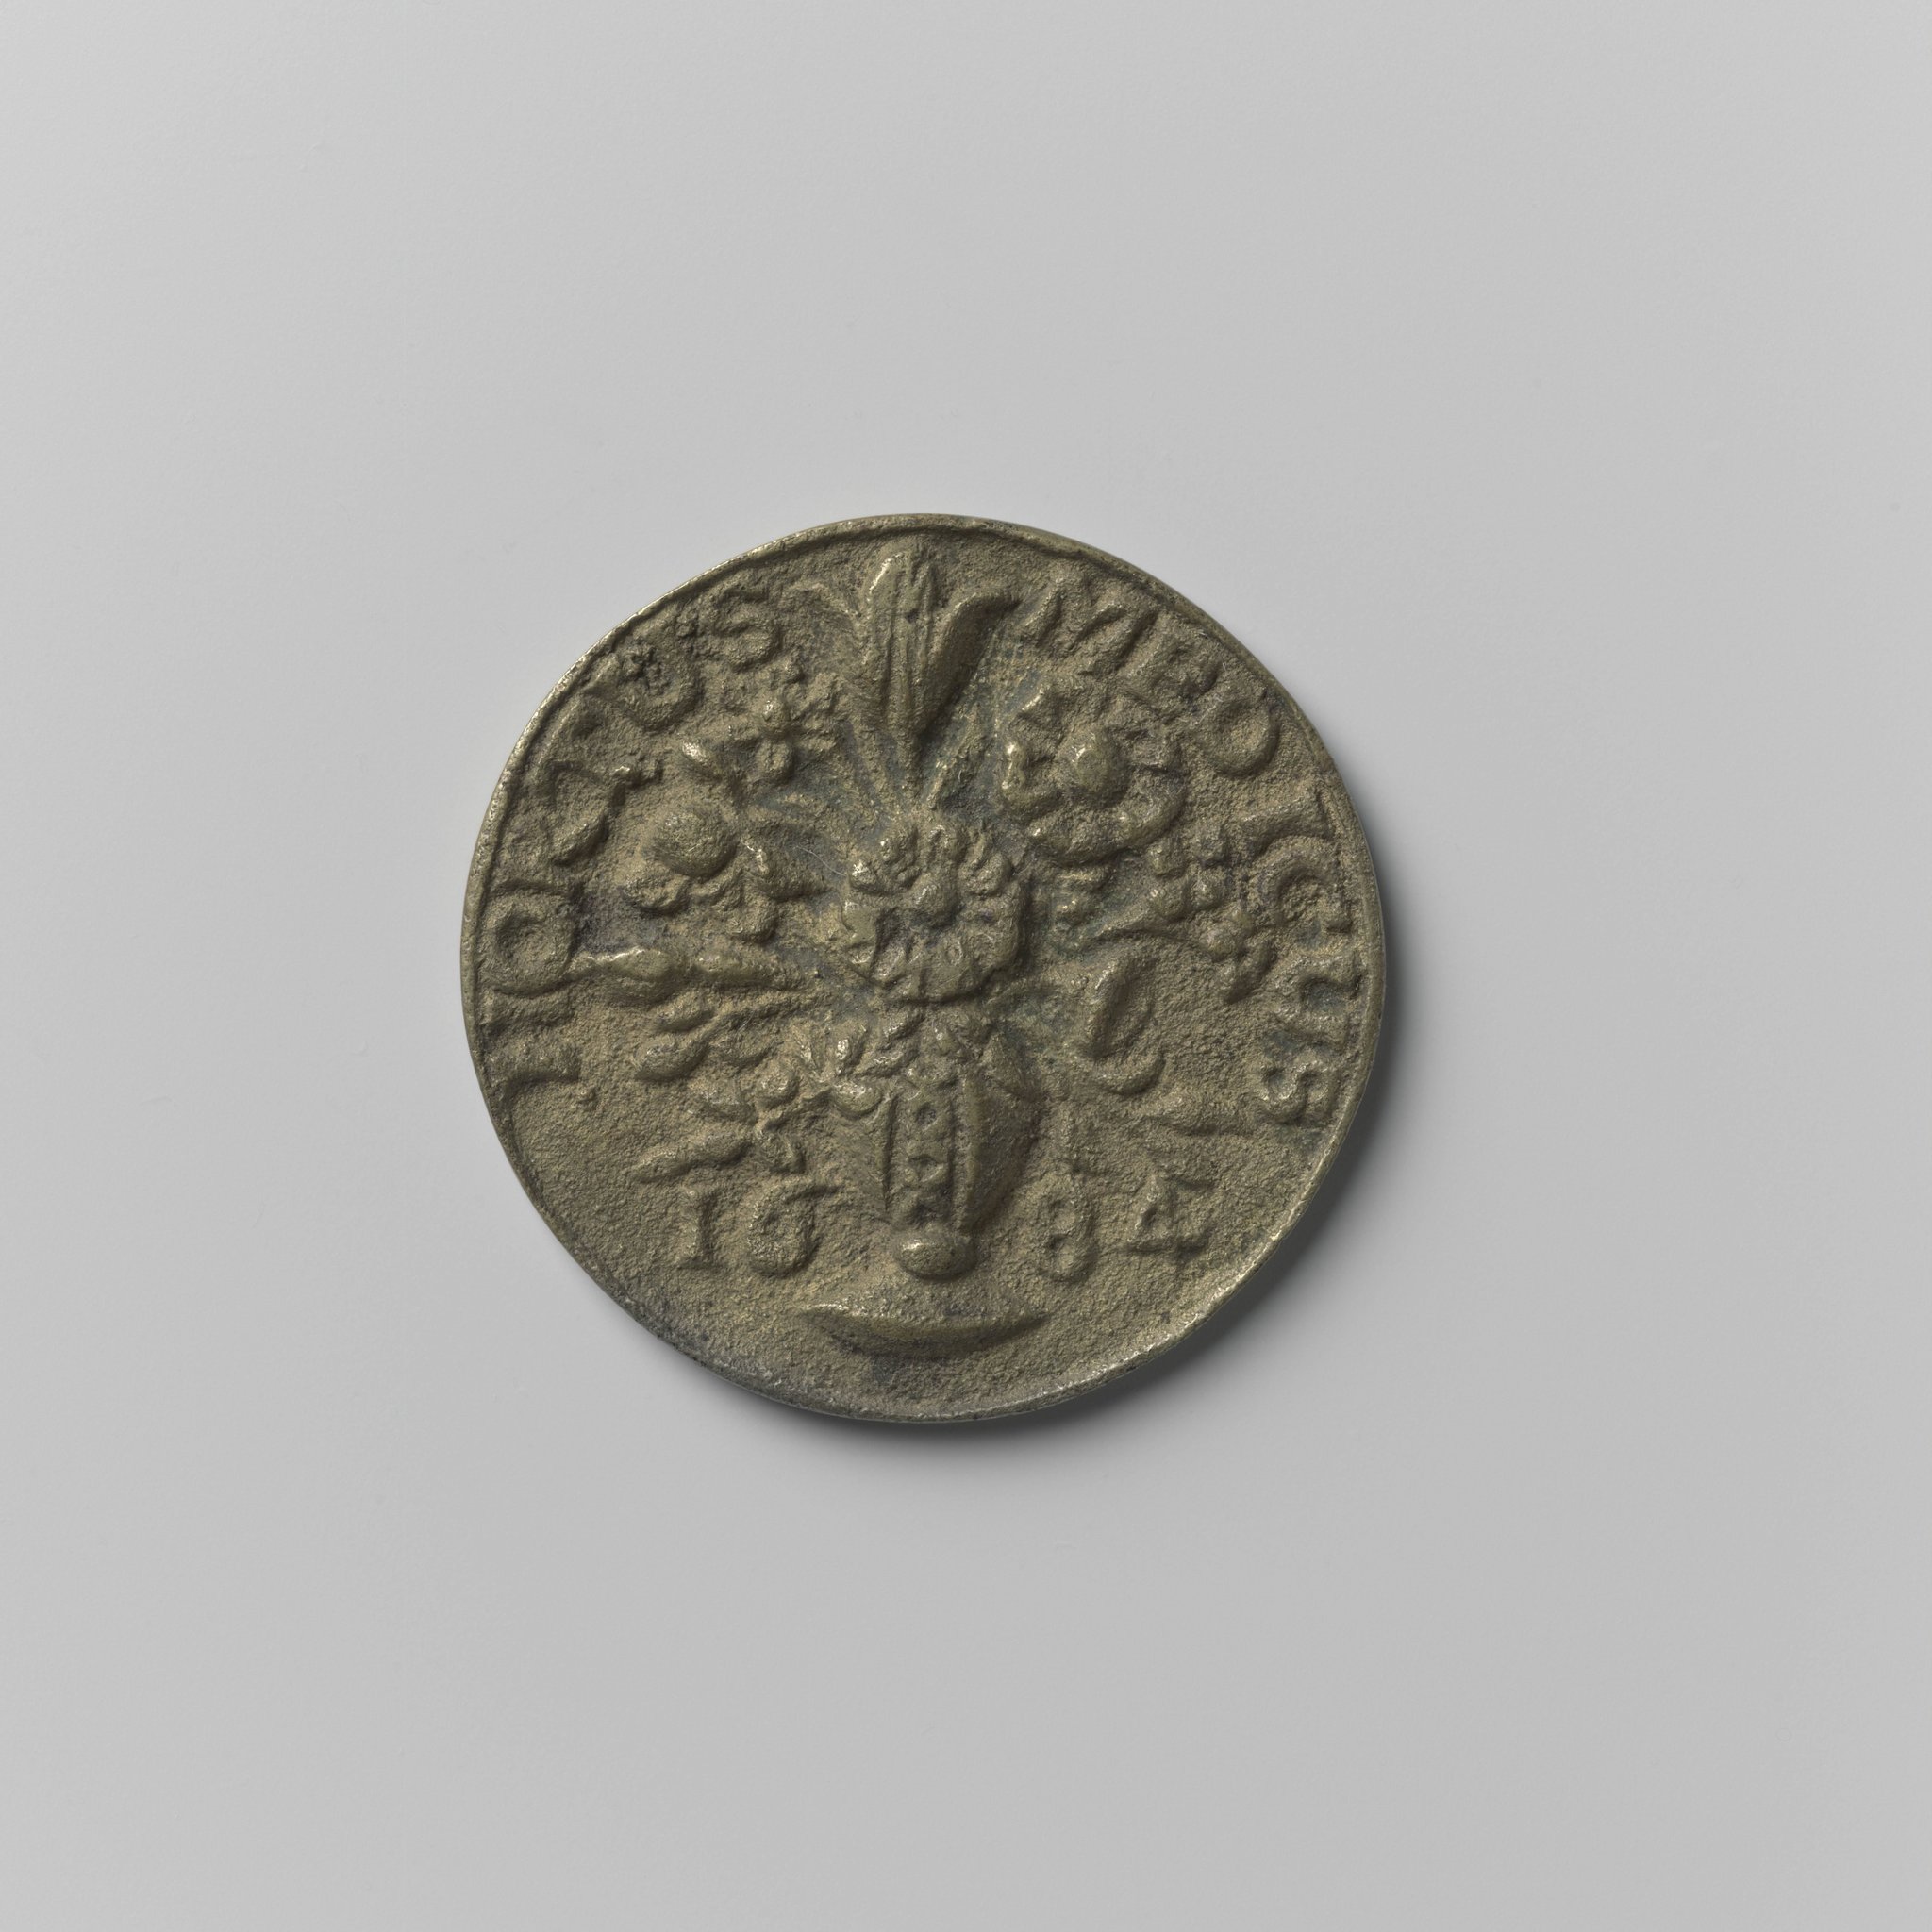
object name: medal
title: Collegium Medicum te Amsterdam, toegangspenning voor de hortus medicus voor apothekersleerlingen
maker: Anonymous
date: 1684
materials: brass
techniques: casting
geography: amsterdam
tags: amsterdam